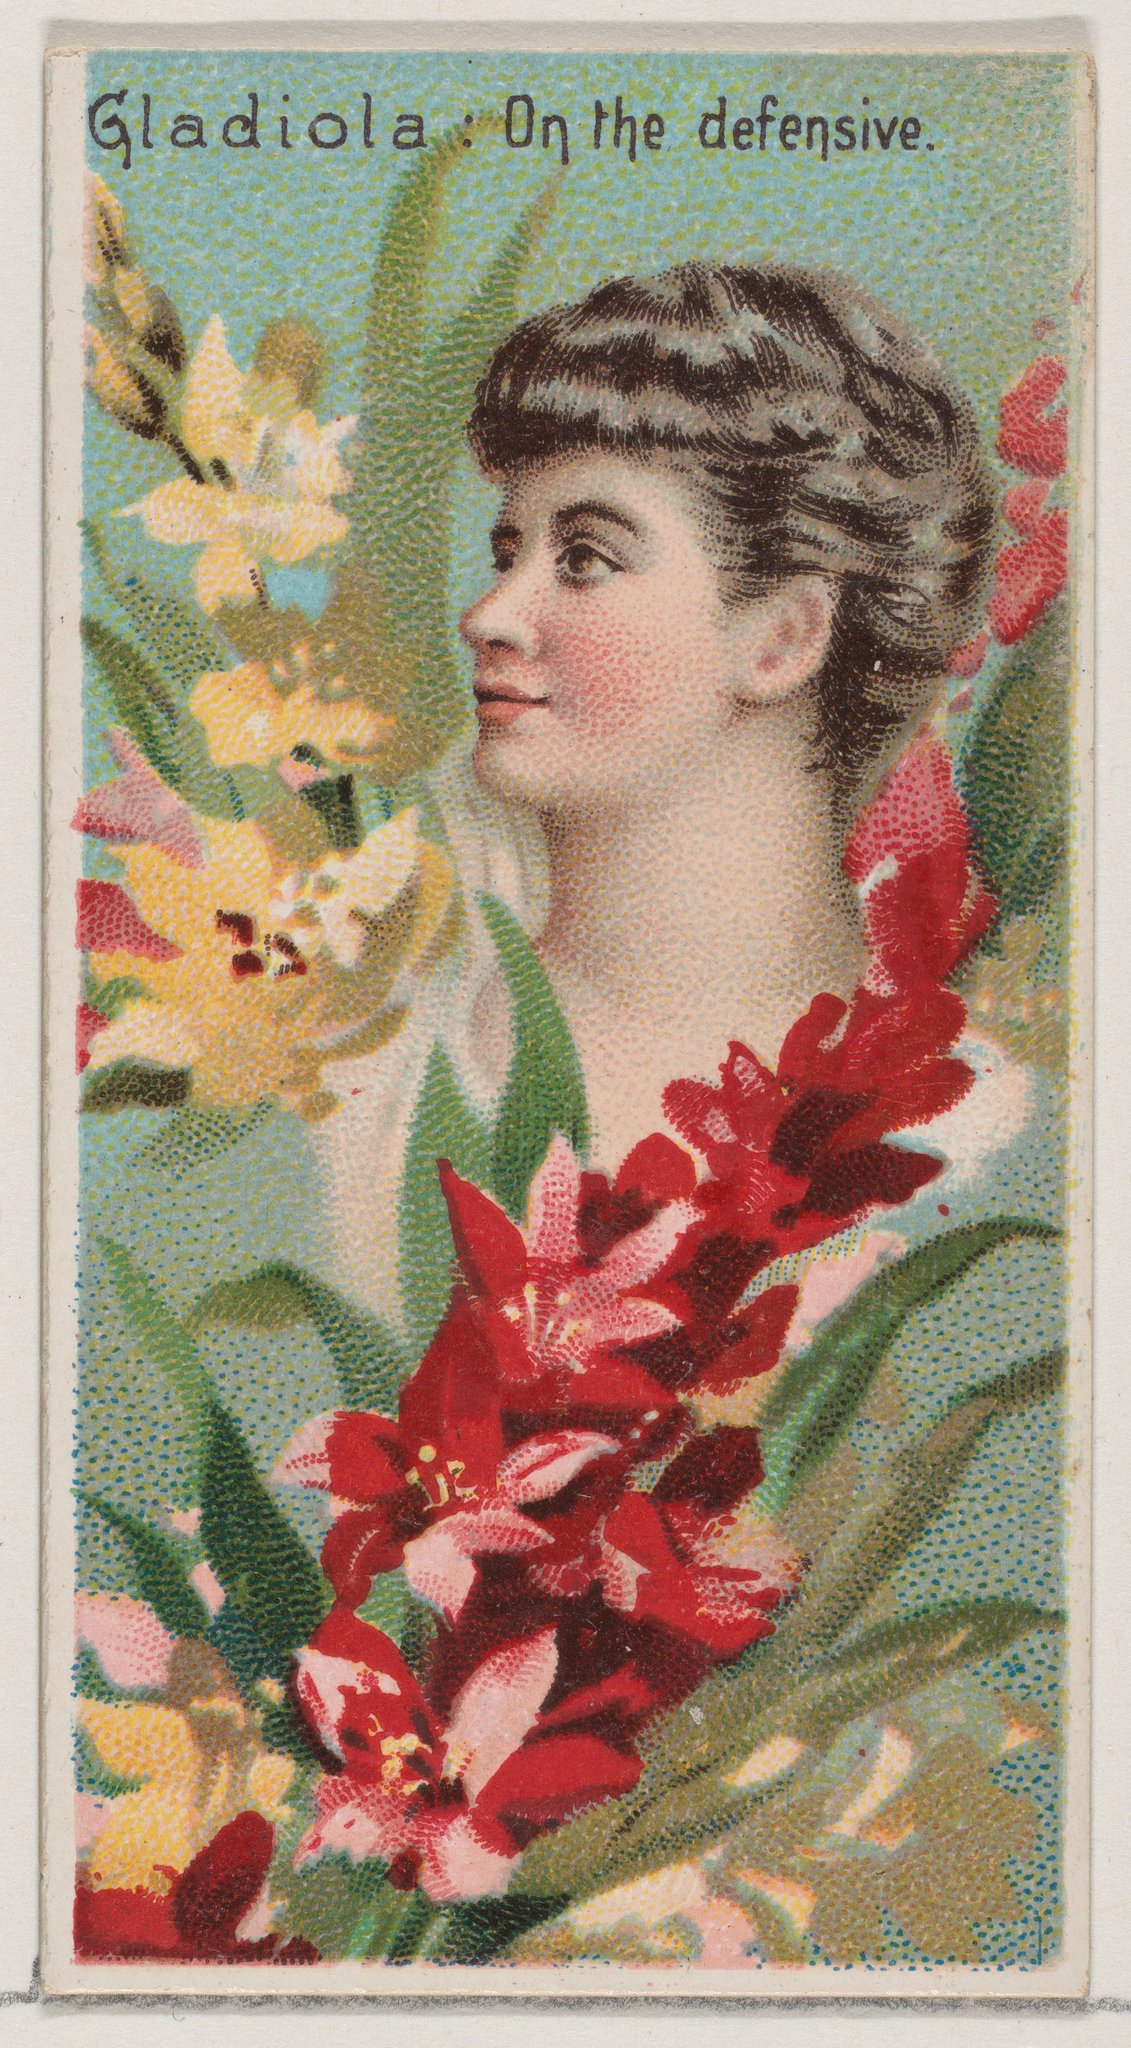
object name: print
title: Gladiola: On the Defensive, from the series Floral Beauties and Language of Flowers (N75) for Duke brand cigarettes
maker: american tobacco company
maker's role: publisher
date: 1892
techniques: color lithograph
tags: women,flowers